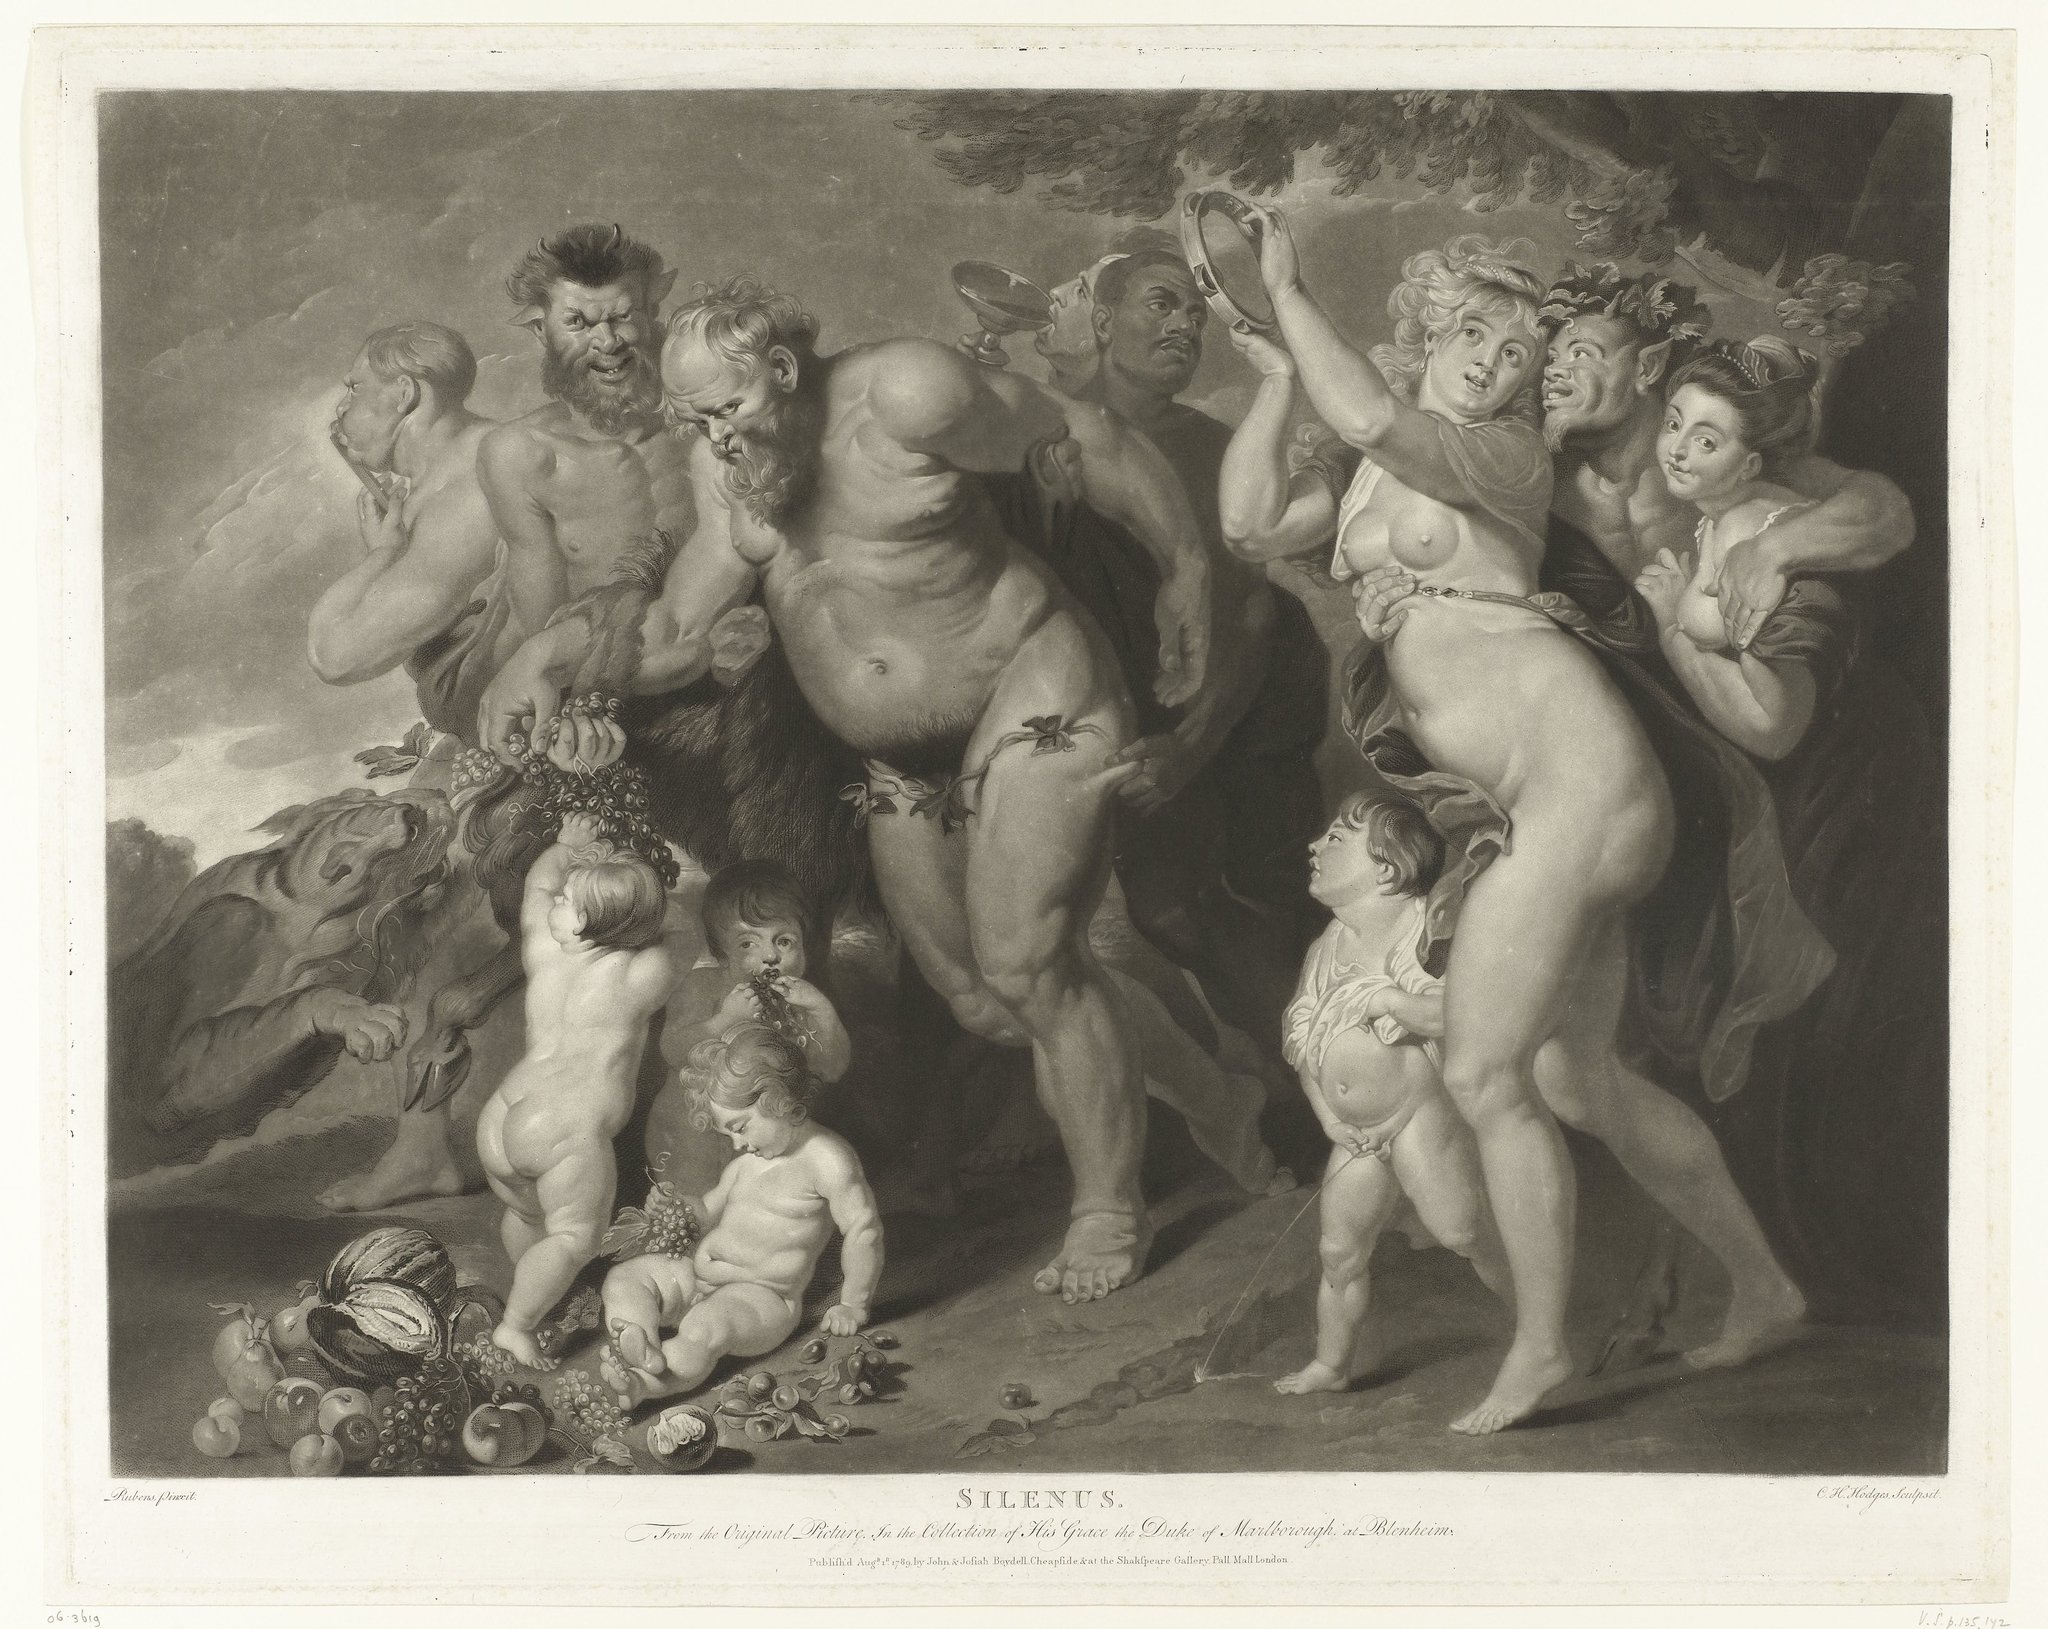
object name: print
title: Bacchanaal met Silenus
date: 1789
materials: paper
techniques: etching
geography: london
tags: (story of) silenus, thiasos, i.e. bacchus' revel-rout, bacchanal without bacchus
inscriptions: collector's mark: Lugt 2228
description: De dronken Silenus wordt ondersteund door saters en bacchanten in een feestelijke stoet met muzikanten.